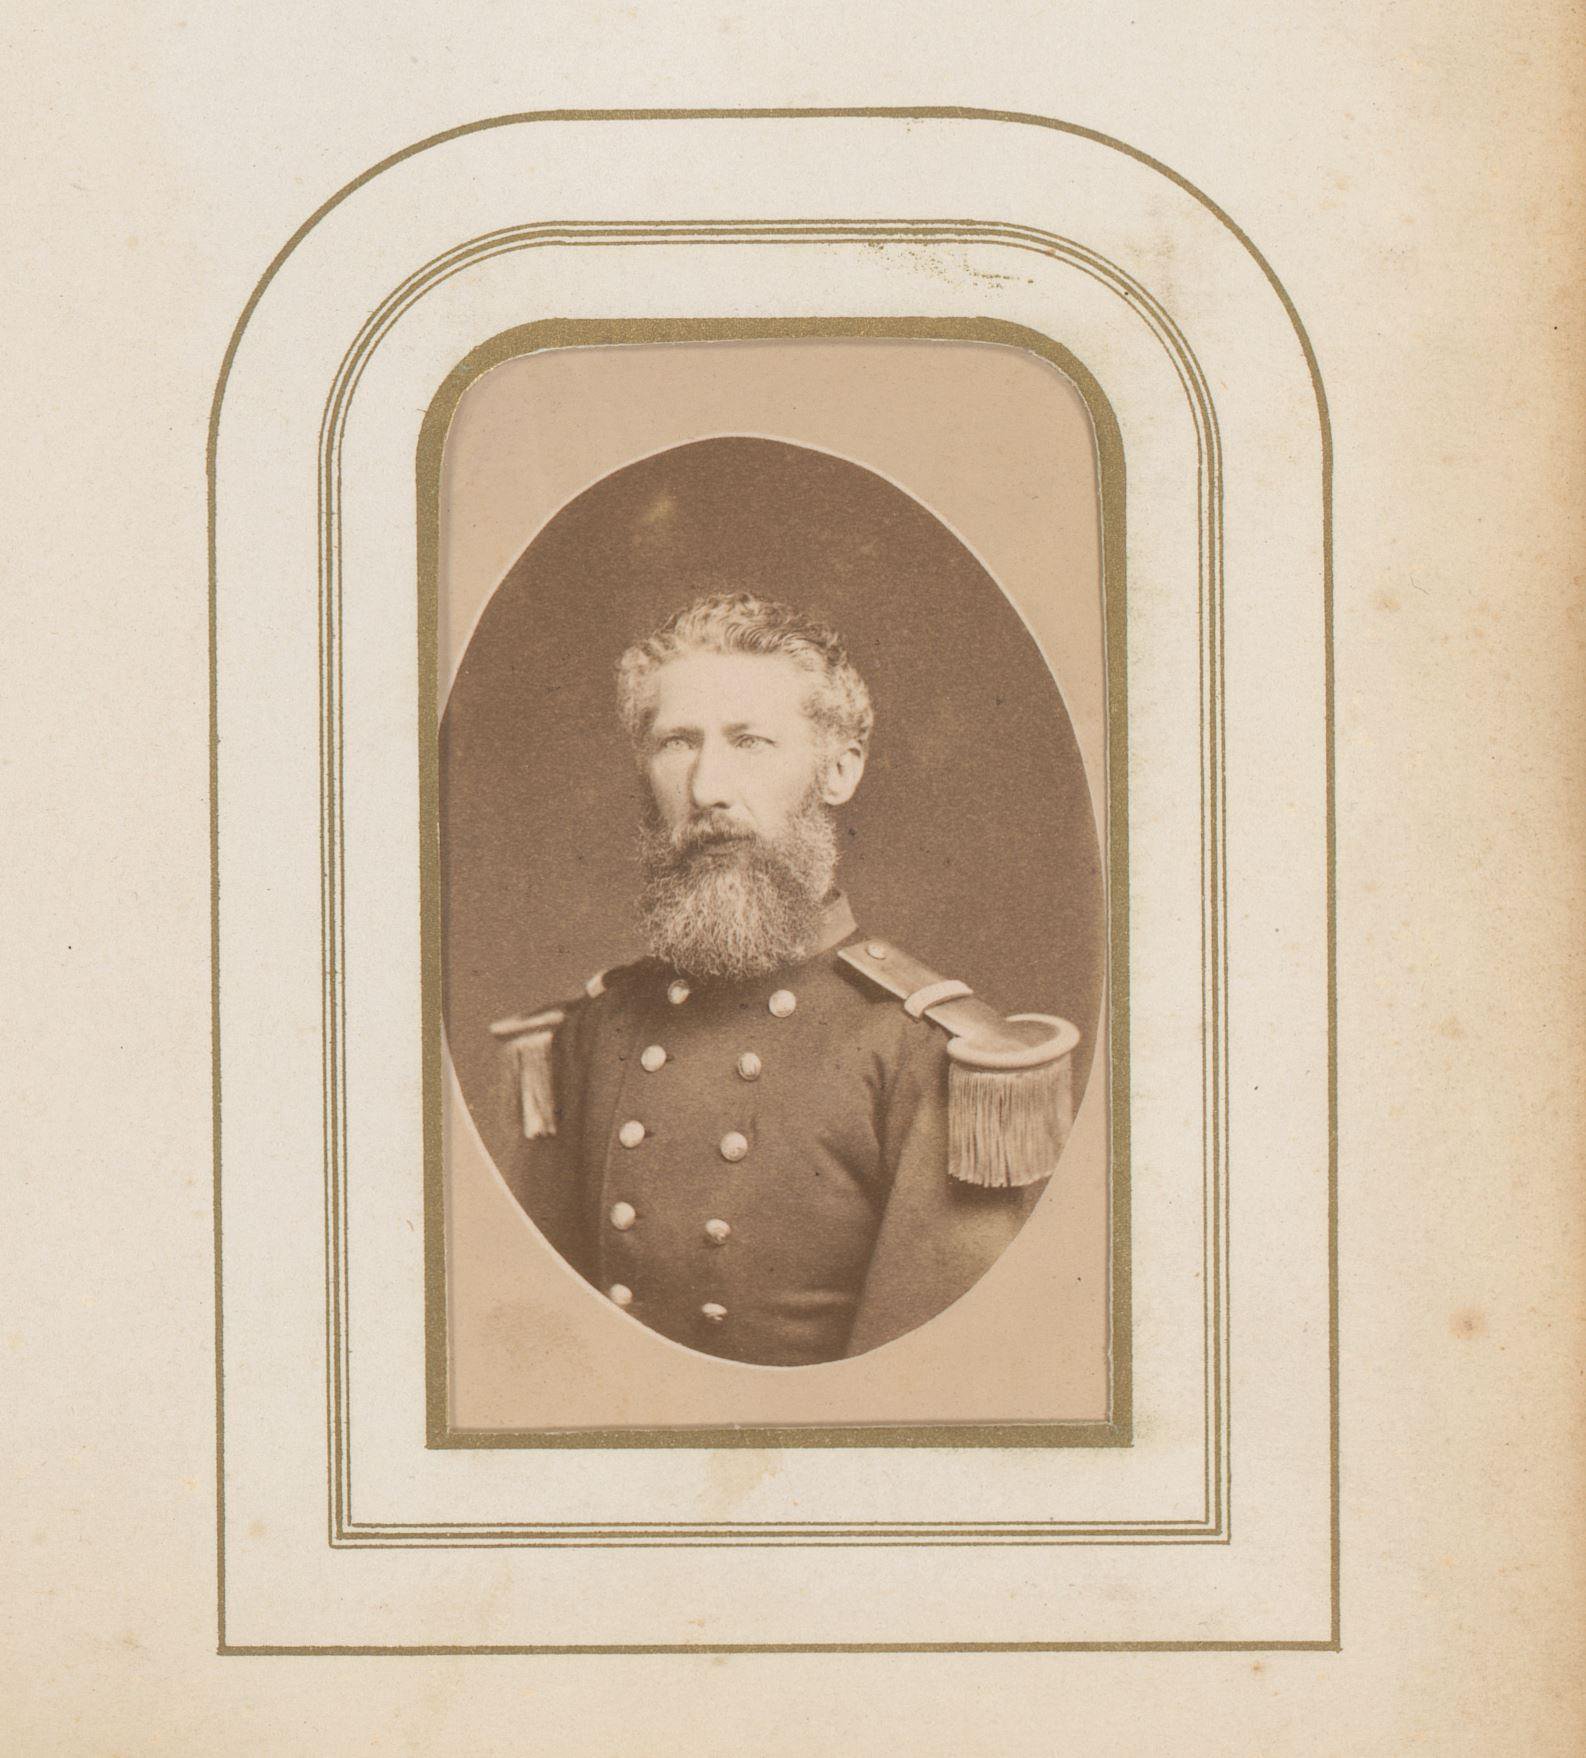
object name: photograph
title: Portret van een man met baard in uniform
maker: auguste chapuis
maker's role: fotograaf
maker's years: 1837-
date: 1868-1888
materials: cardboard, photographic support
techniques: albumen print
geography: bergen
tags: historical persons, (military) uniforms, beard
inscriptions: inscription: ‘Photographie du hainaut/ Chapuis/ 15, Rue du Séminaire/ Mons’